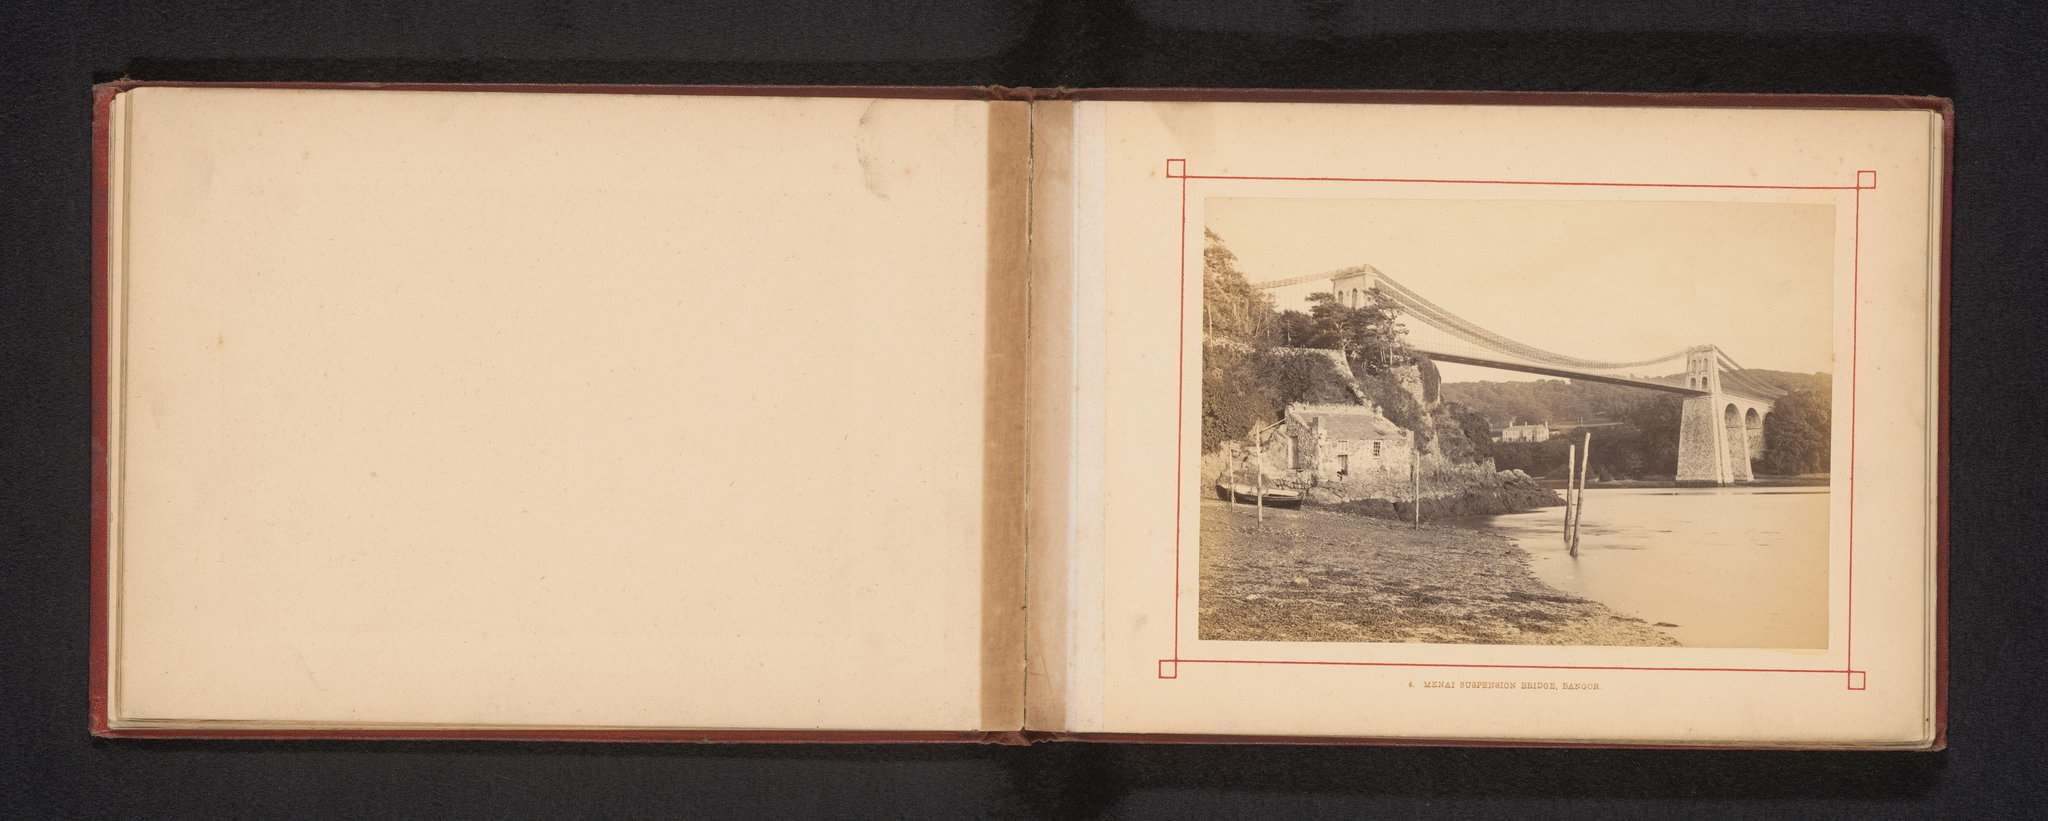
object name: photograph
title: Menai Suspension Bridge, Bangor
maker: francis bedford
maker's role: print maker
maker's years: 1815-1894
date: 1865-1870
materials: photographic support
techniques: albumen print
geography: bangor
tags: city-view, and landscape with man-made constructions, suspension bridge, bridge